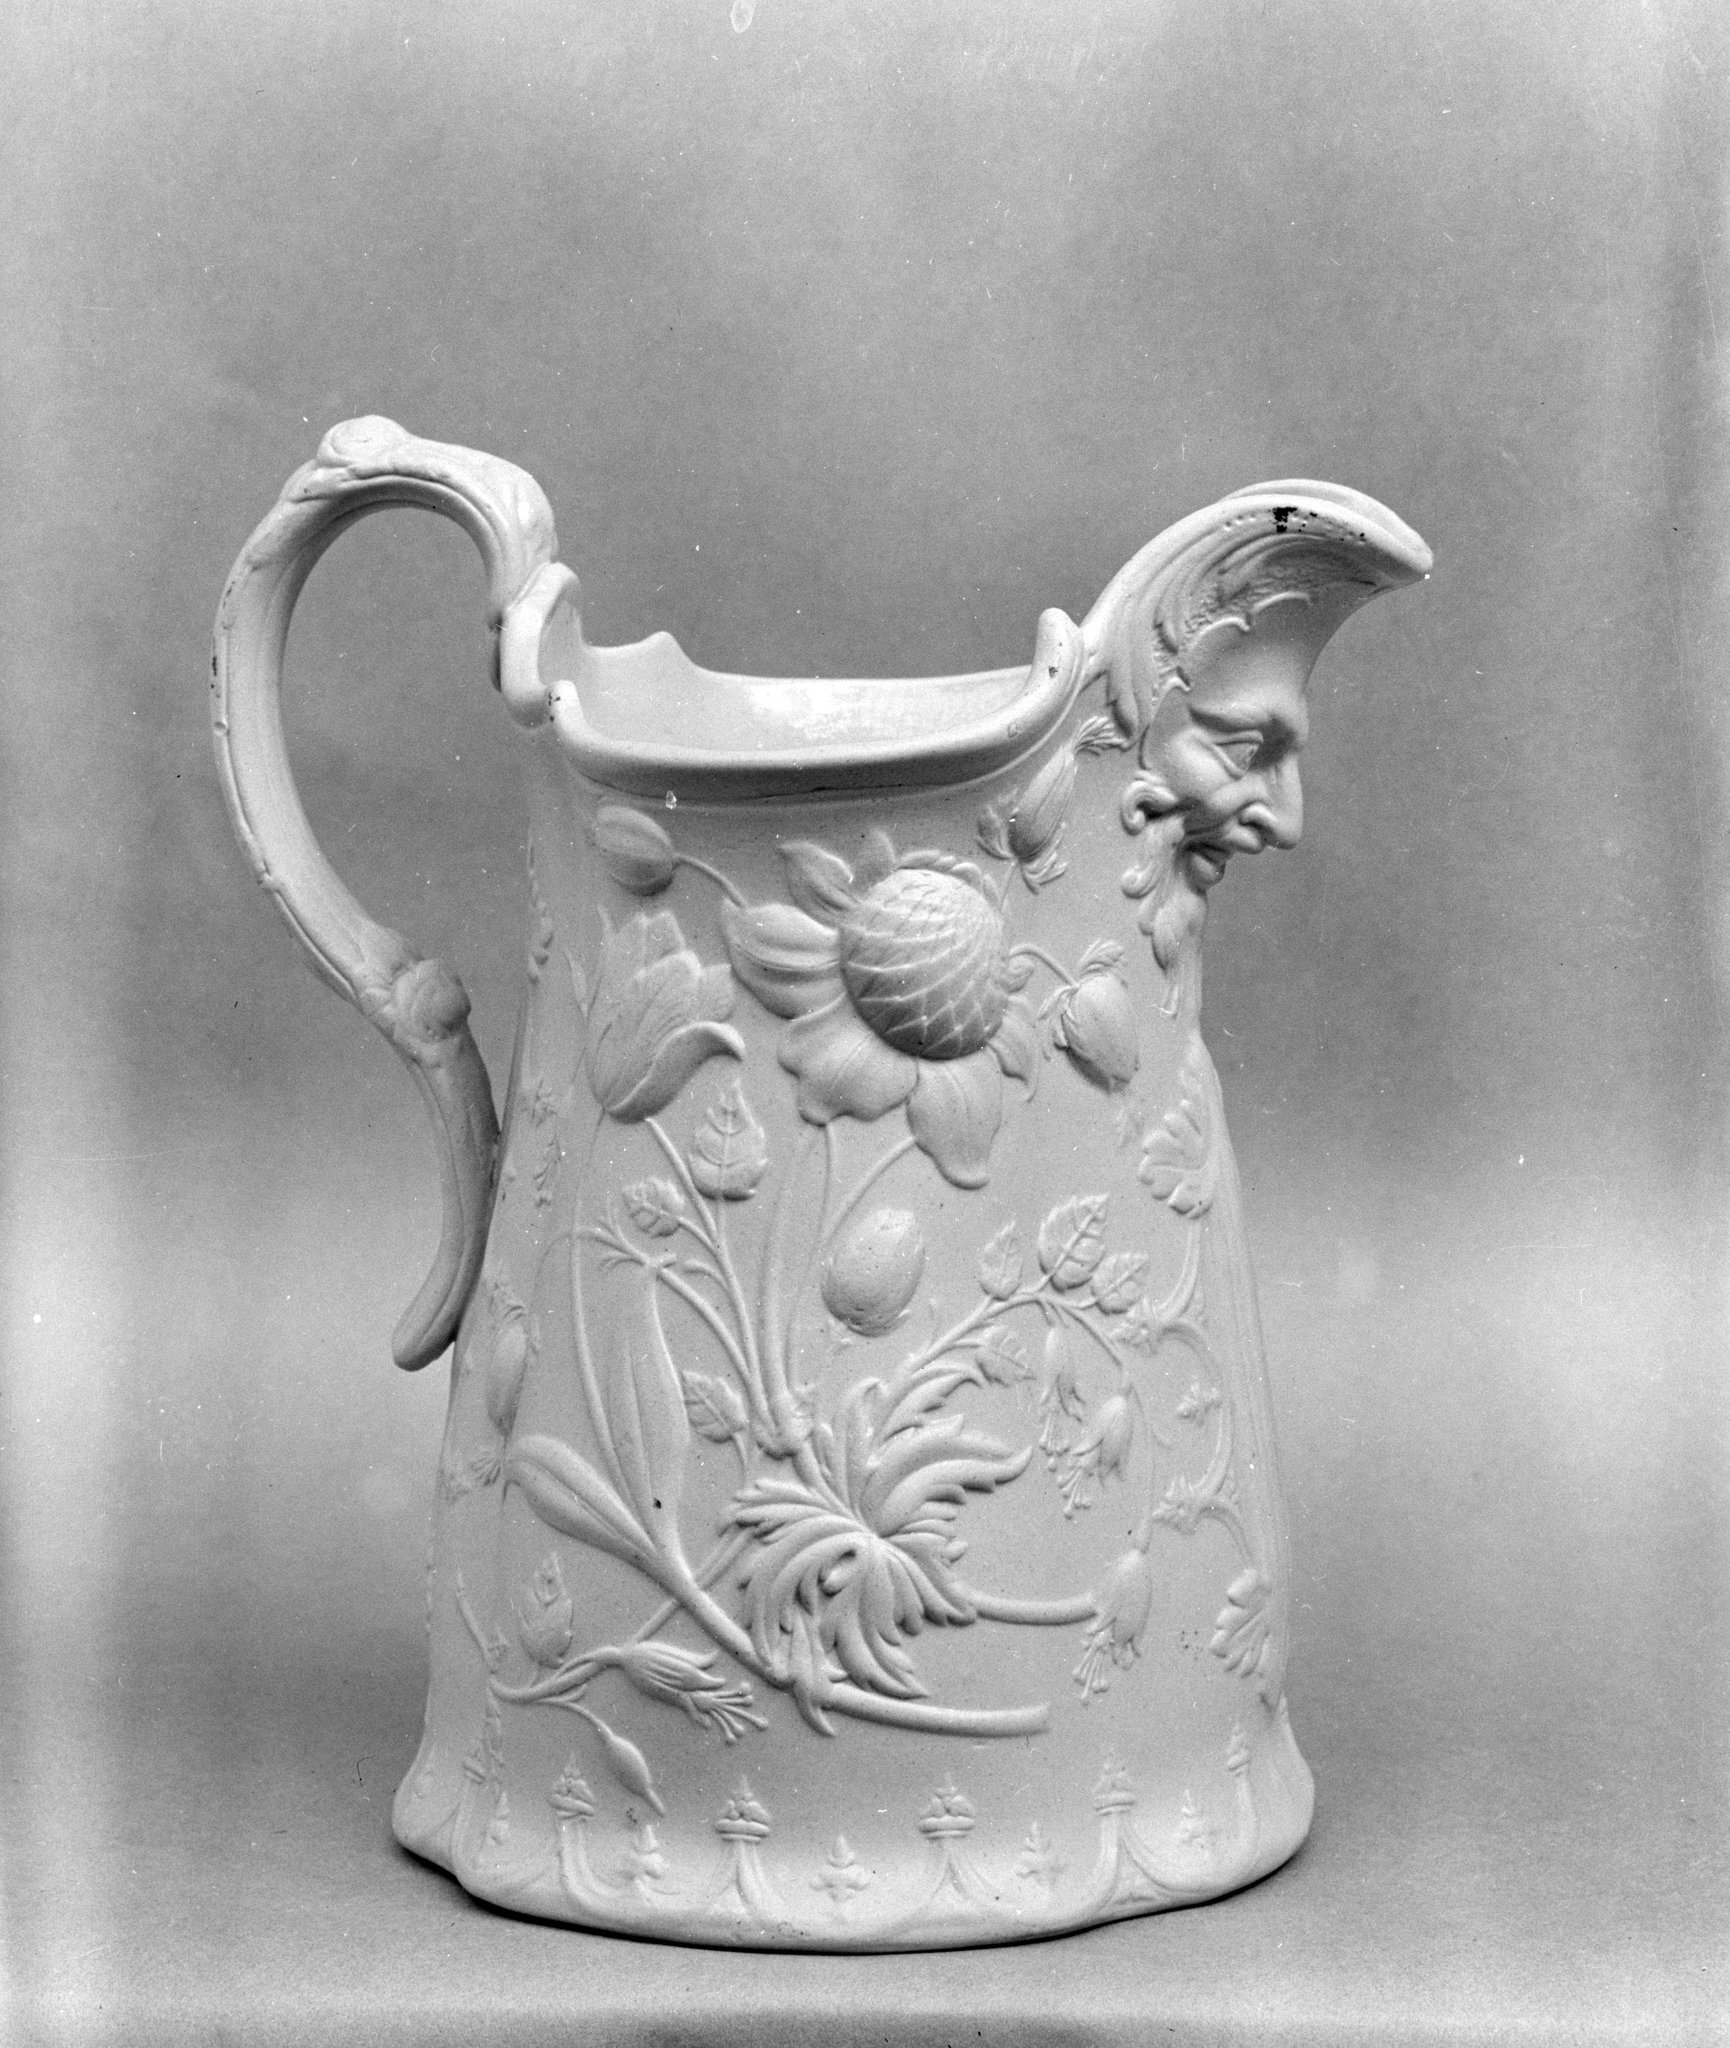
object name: pitcher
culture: american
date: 1830-1870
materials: porcelain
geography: united states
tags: flowers